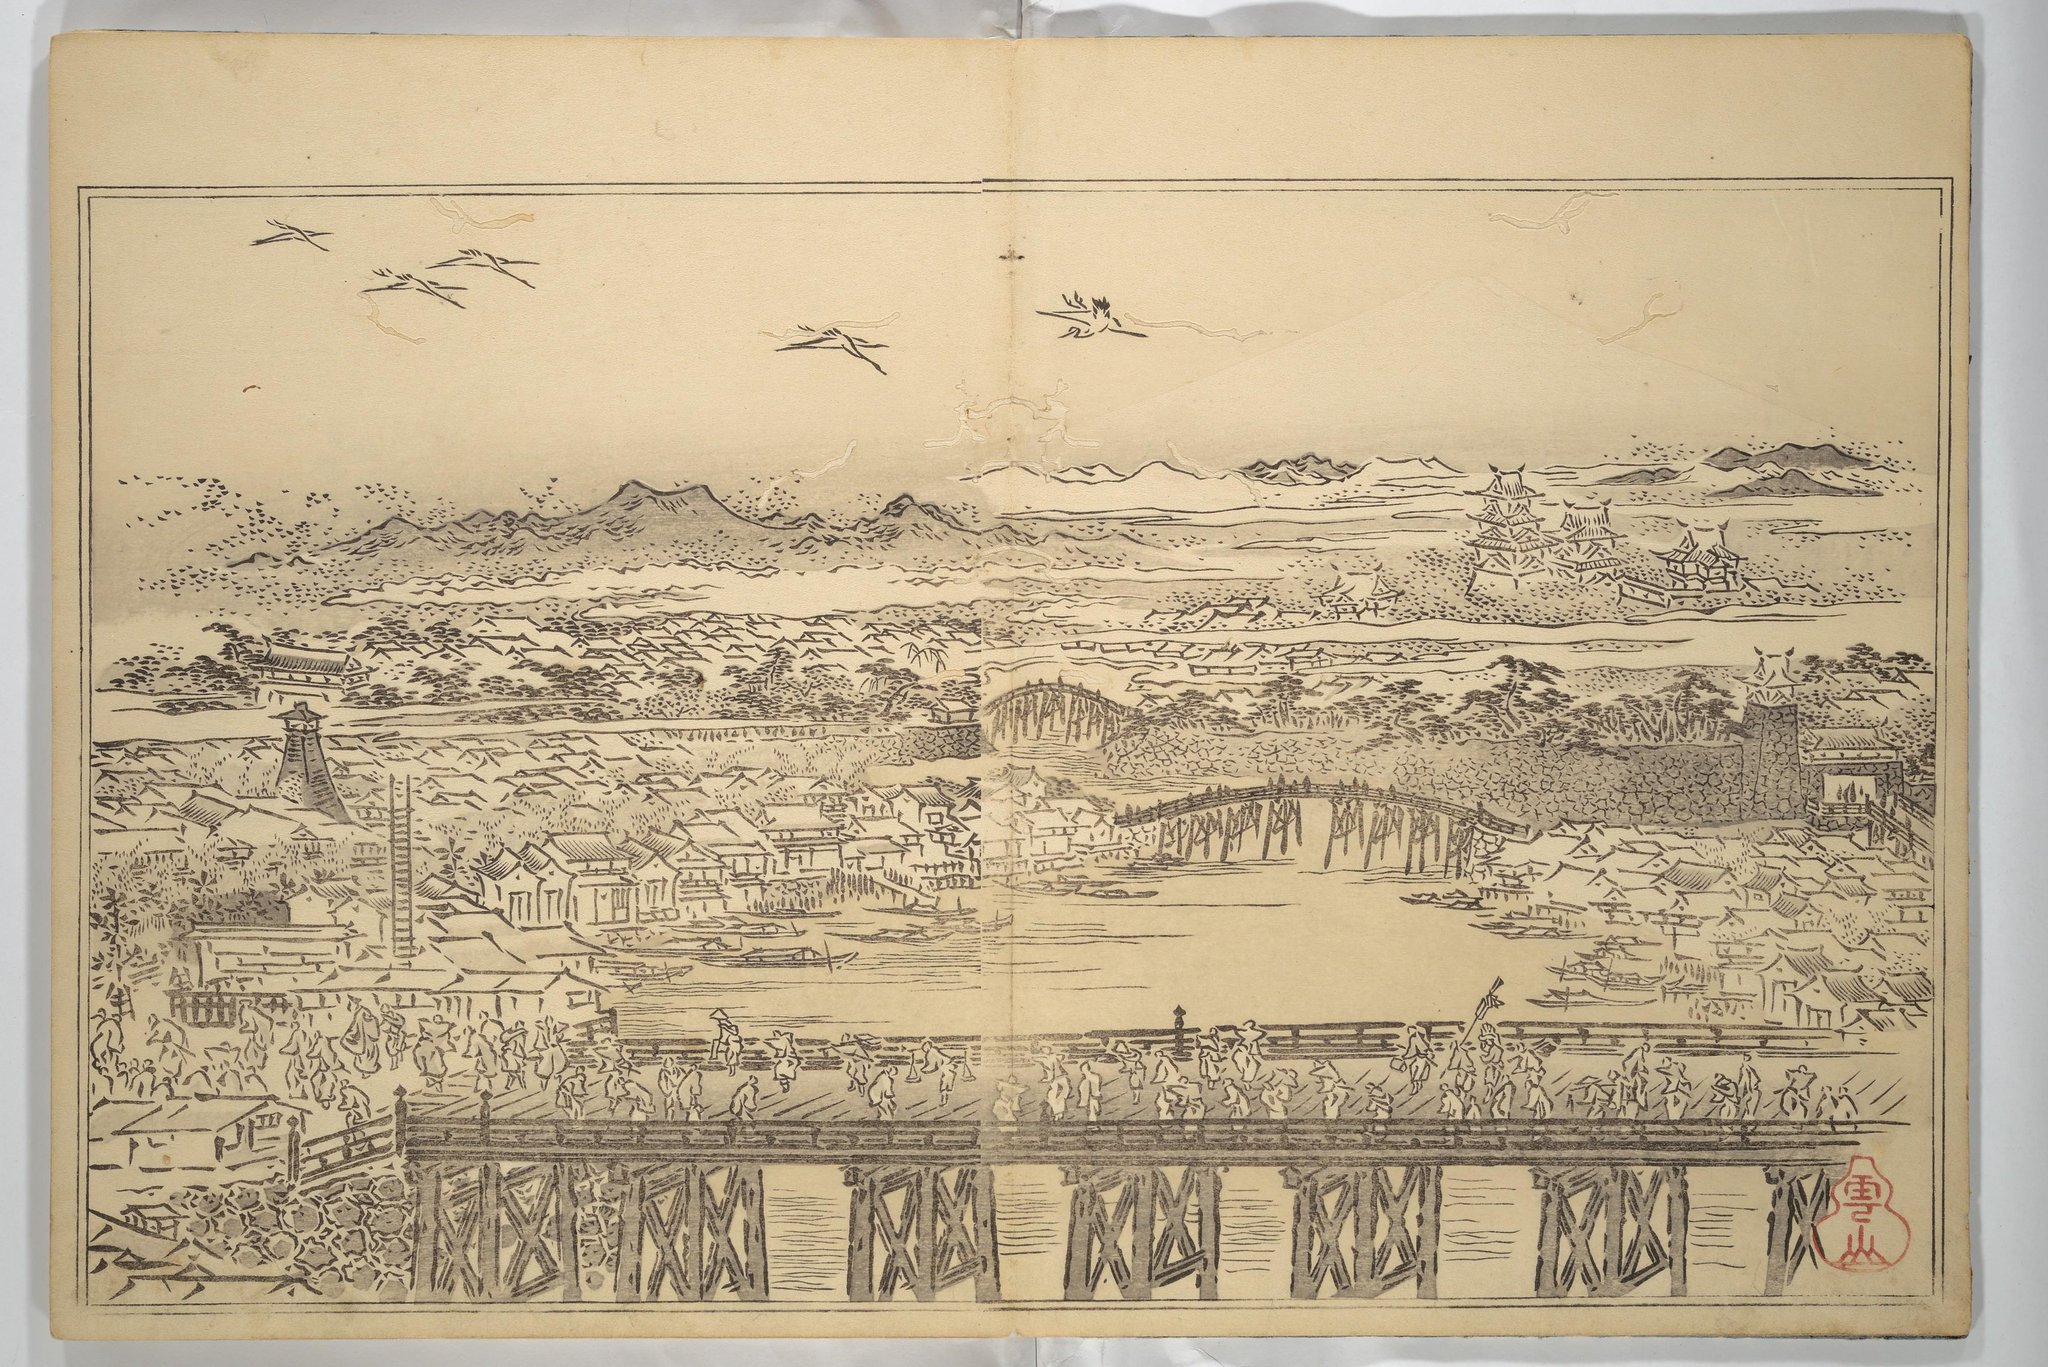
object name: illustrated book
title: The Colors of Spring (Haru no iro) 春の色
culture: japanese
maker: kitagawa utamaro 喜多川歌麿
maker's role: artist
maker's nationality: japanese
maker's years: 1754-1806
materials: ink, paper, pigment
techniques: woodblock print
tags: bridges,towns,rivers